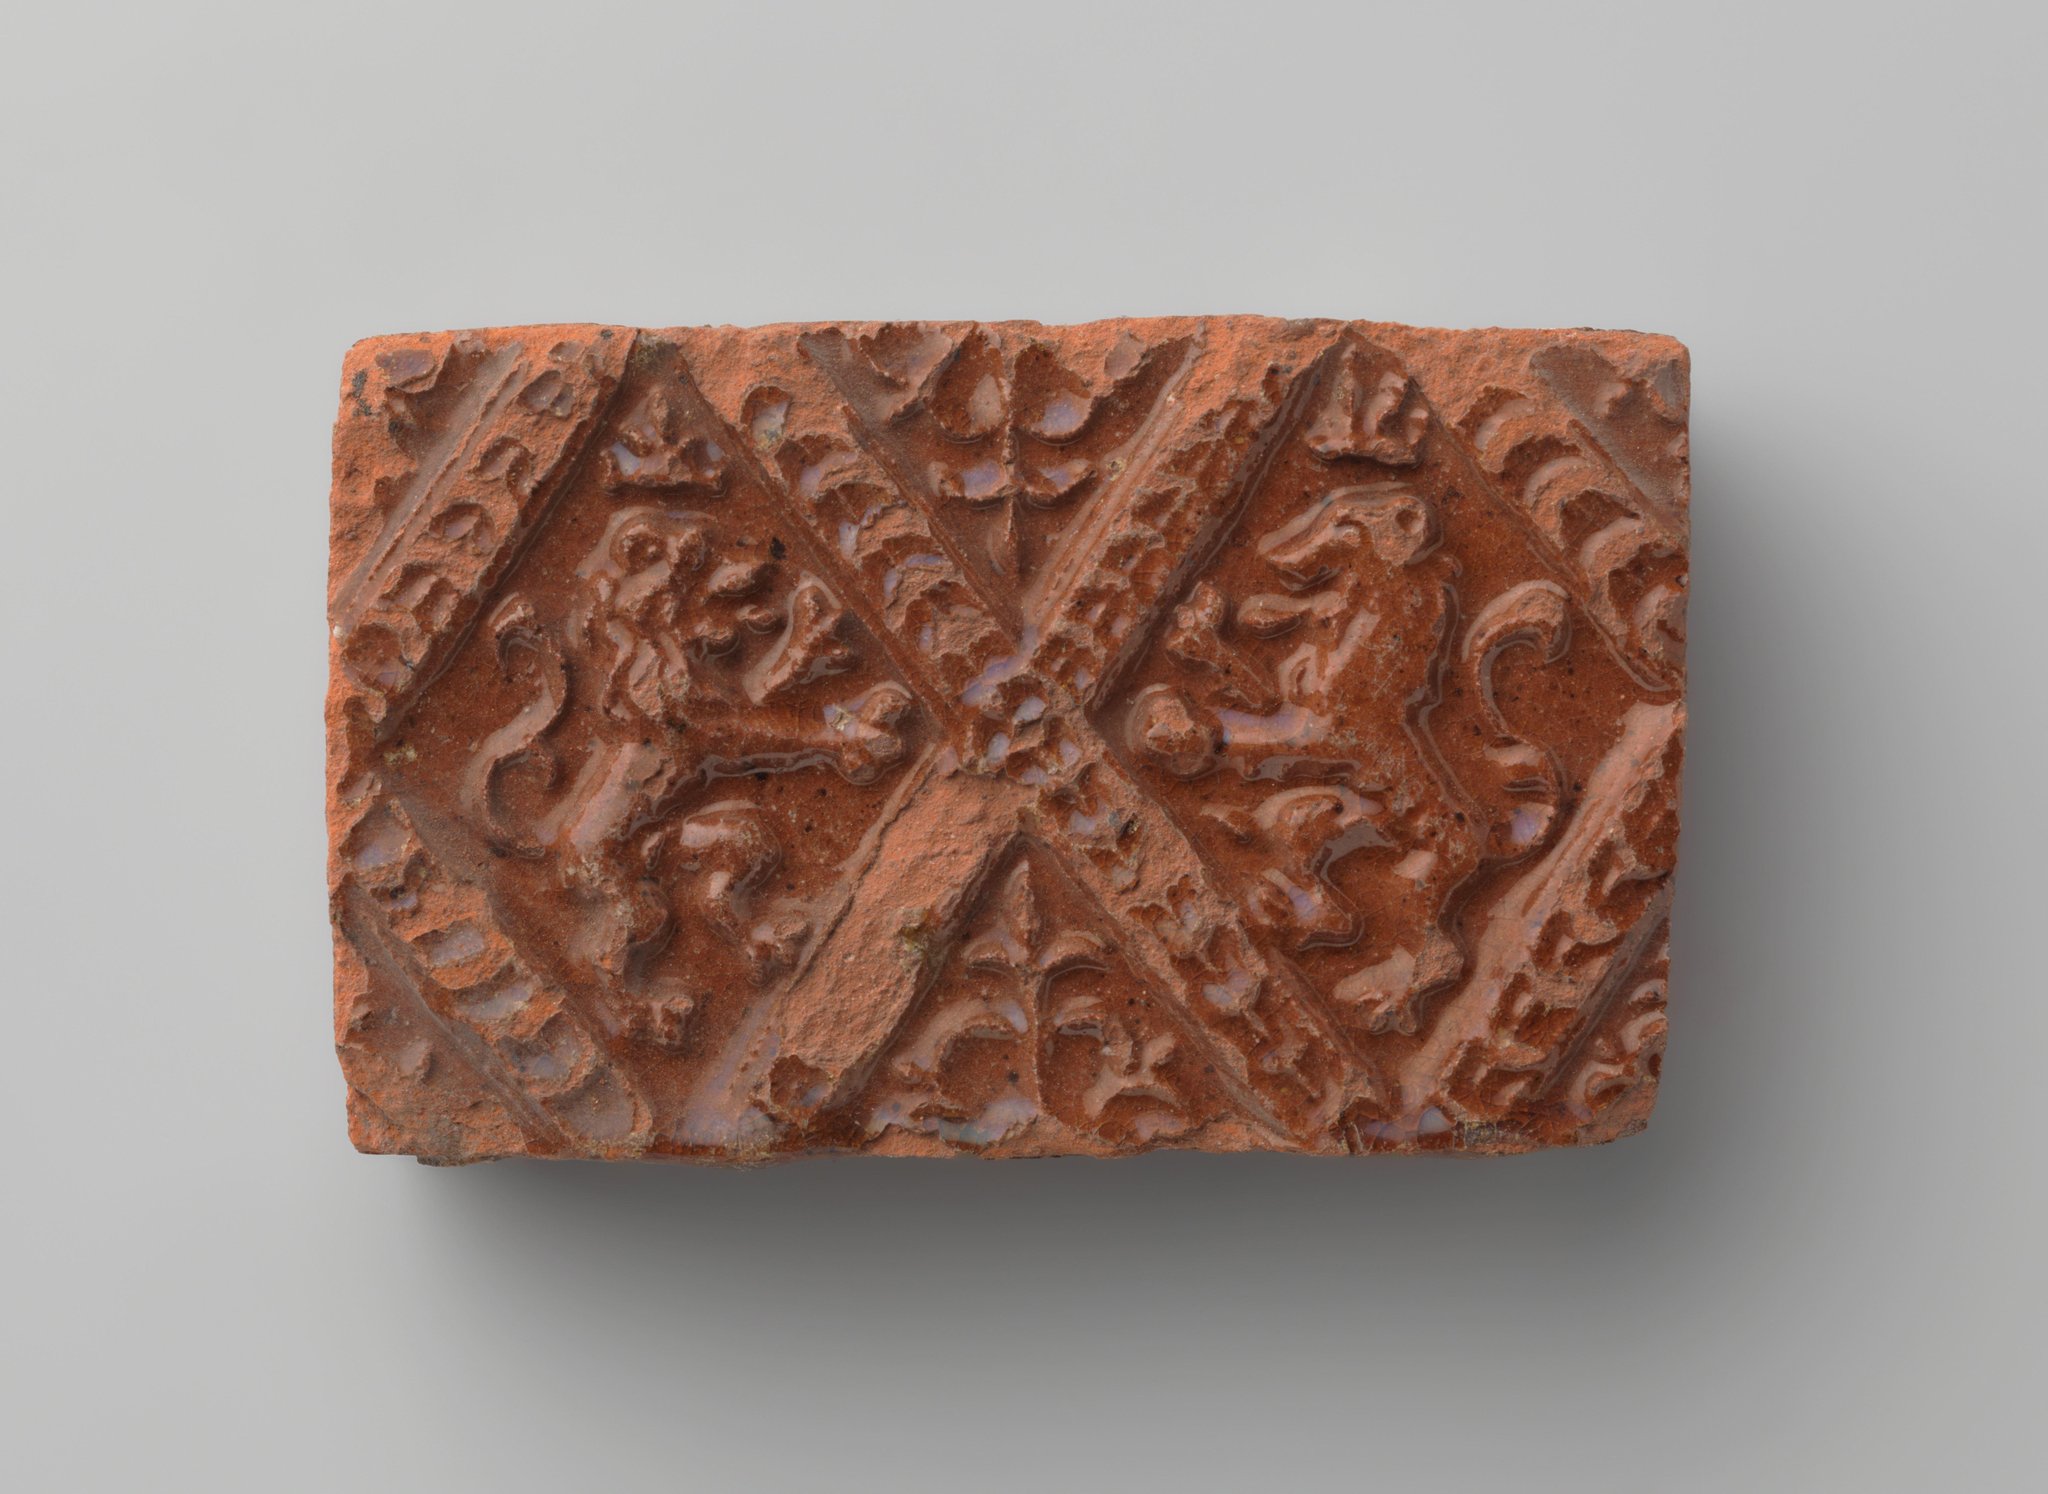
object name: hearthstone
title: Haardsteen met voorstelling van twee klimmende leeuwen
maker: Anonymous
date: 1875-1900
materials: earthenware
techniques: printing, firing, vitrification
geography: netherlands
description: Haardsteen met voorstelling van twee klimmende leeuwen, geplaatst in geprofileerde ruit. De halve ruiten aan de boven- en onderkant zijn opgevuld met pijlmotief. Geglazuurd.